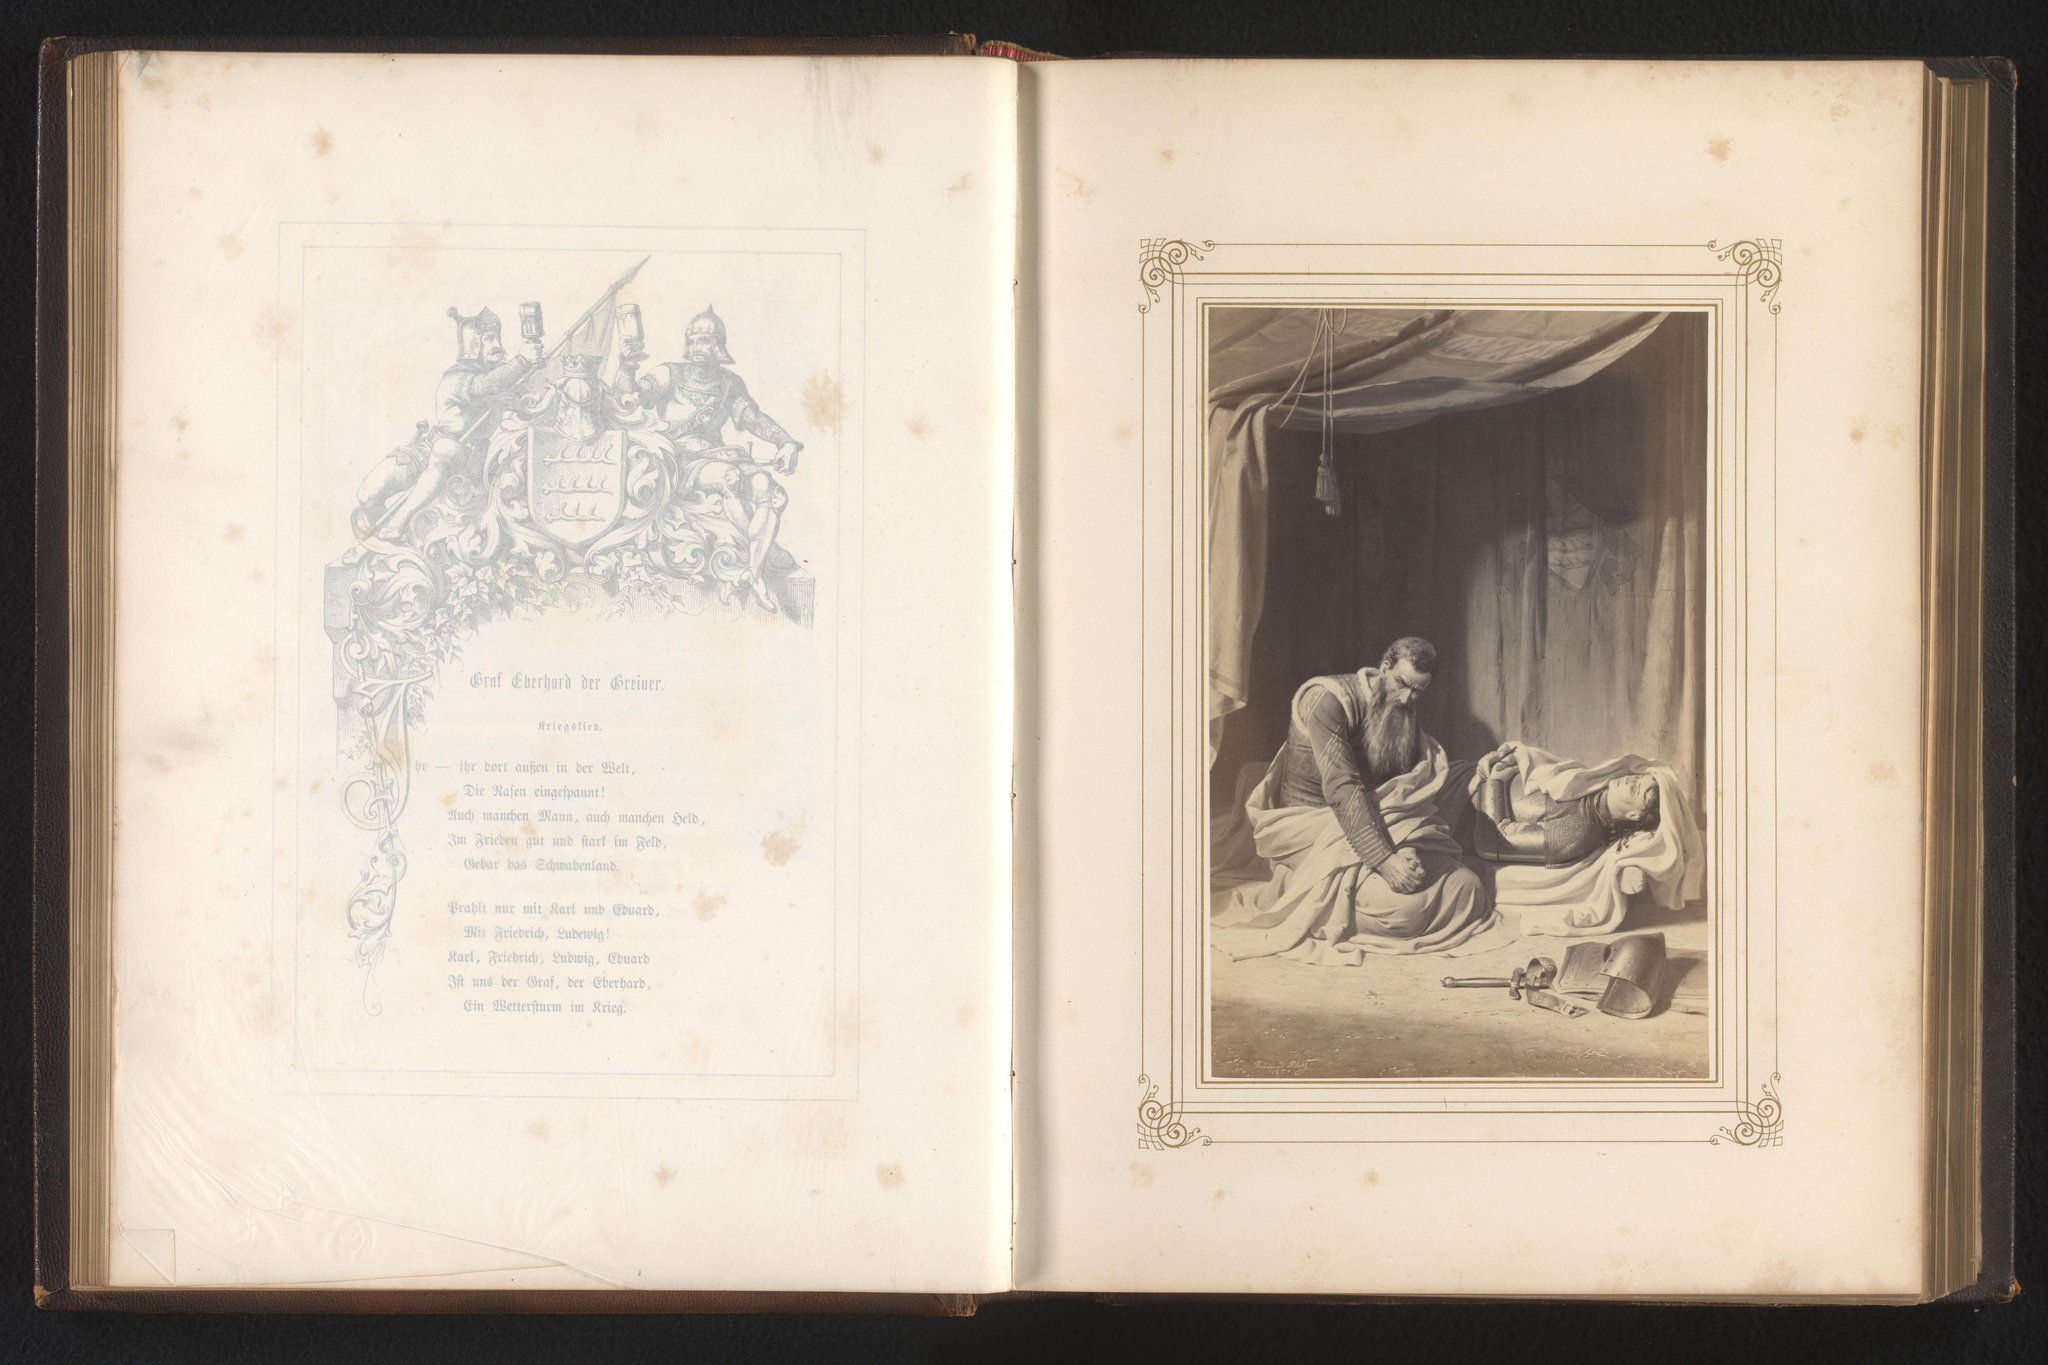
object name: reproduction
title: Ferd. Piloty: Graf Eberhard der Greiner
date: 1860-1862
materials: paper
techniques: albumen print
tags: other sovereign (with title)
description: Foto op ongenummerde pagina na pagina 72.